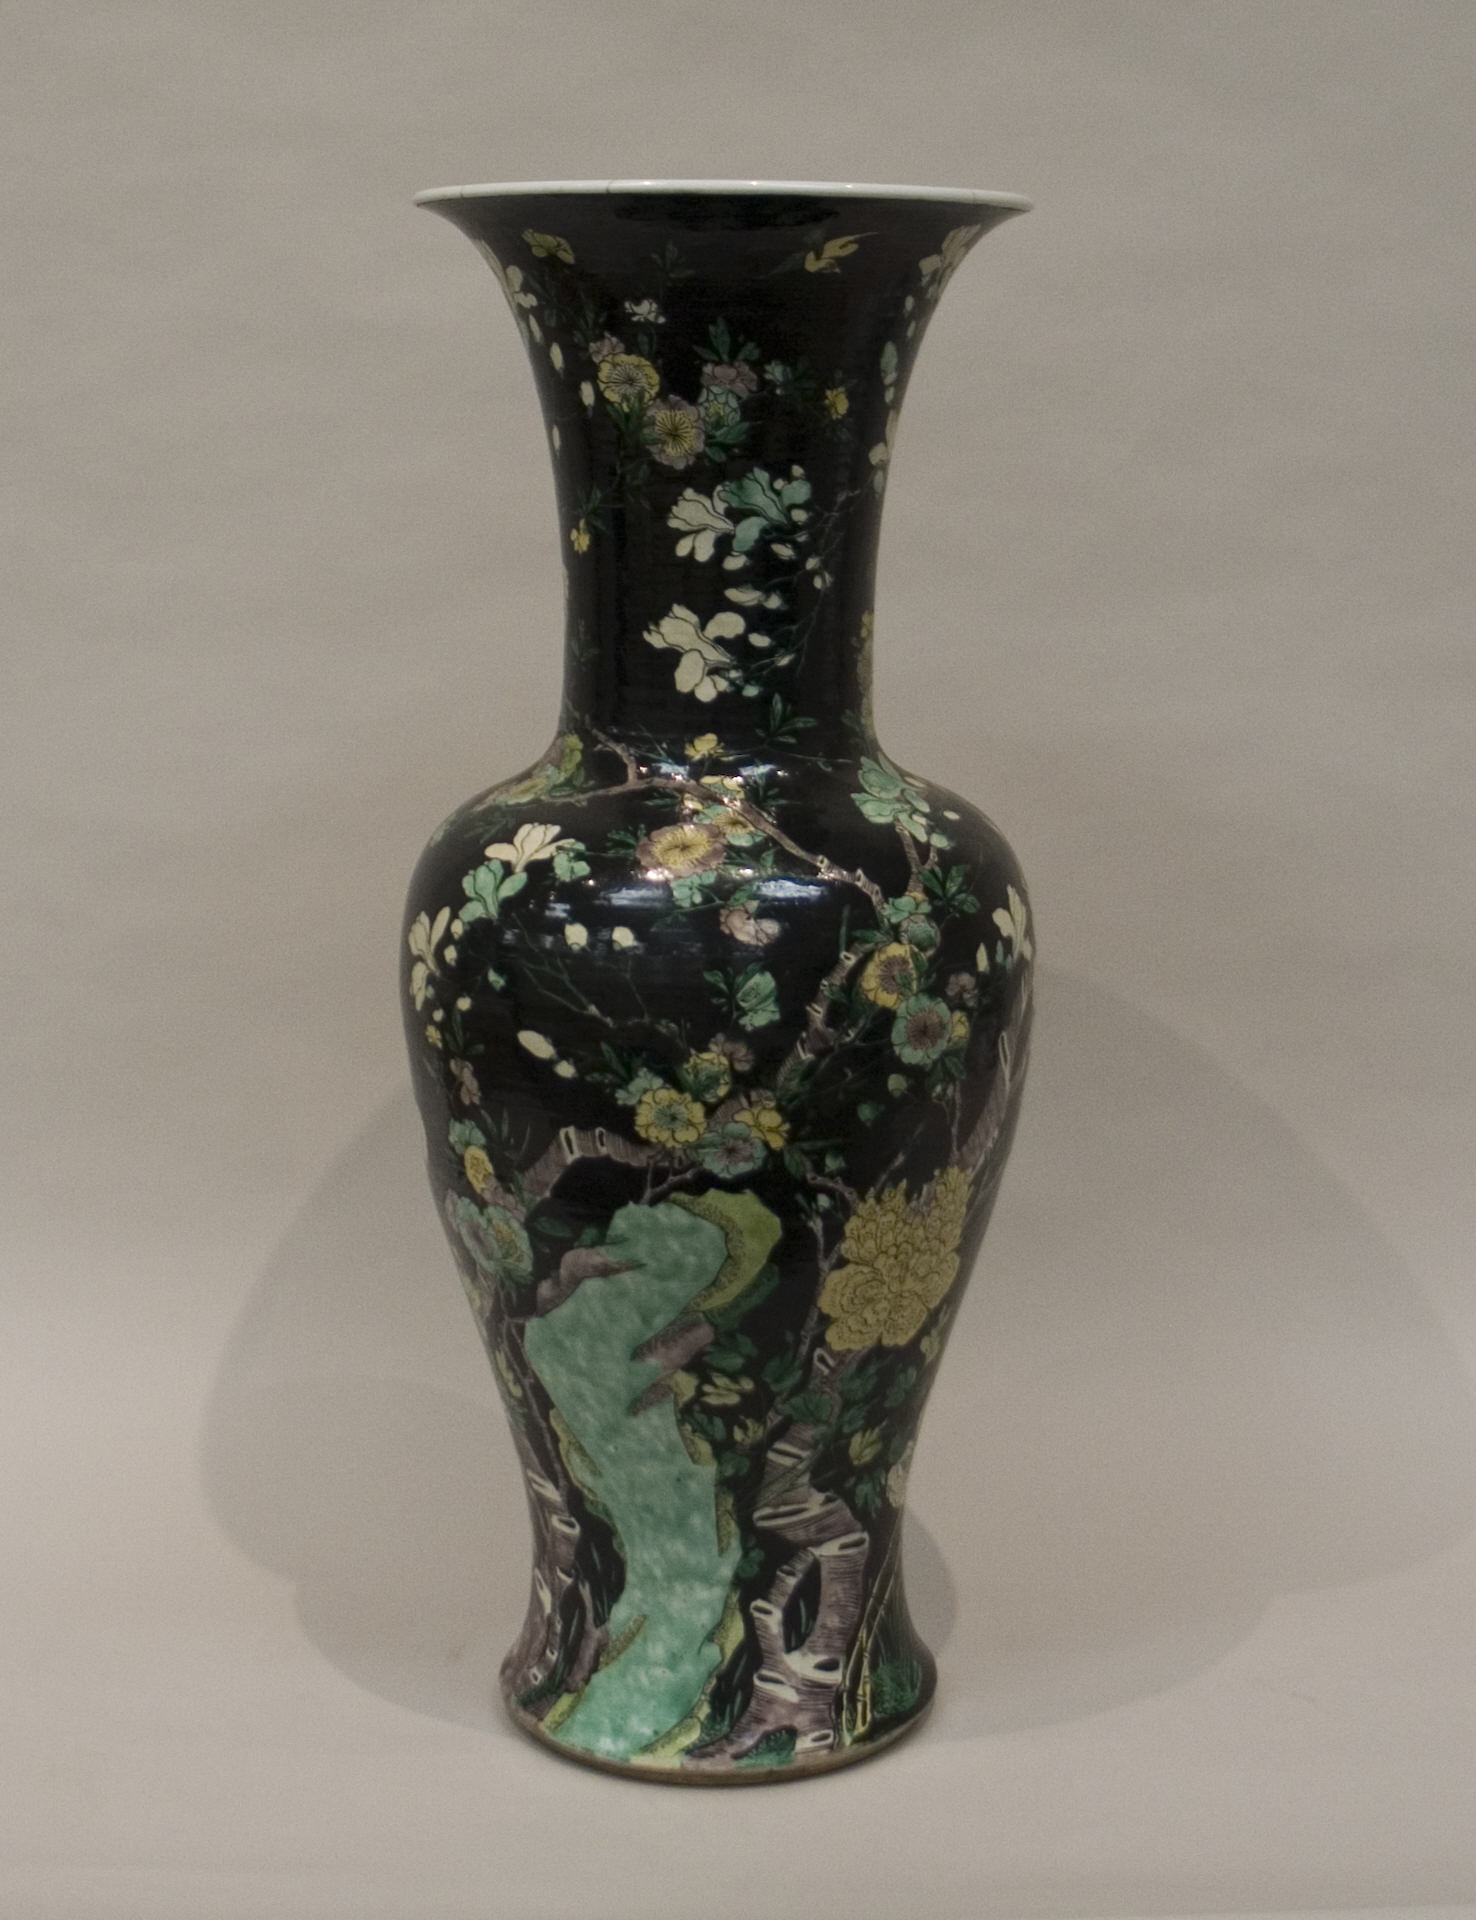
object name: vase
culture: chinese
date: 1662-1722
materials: porcelain